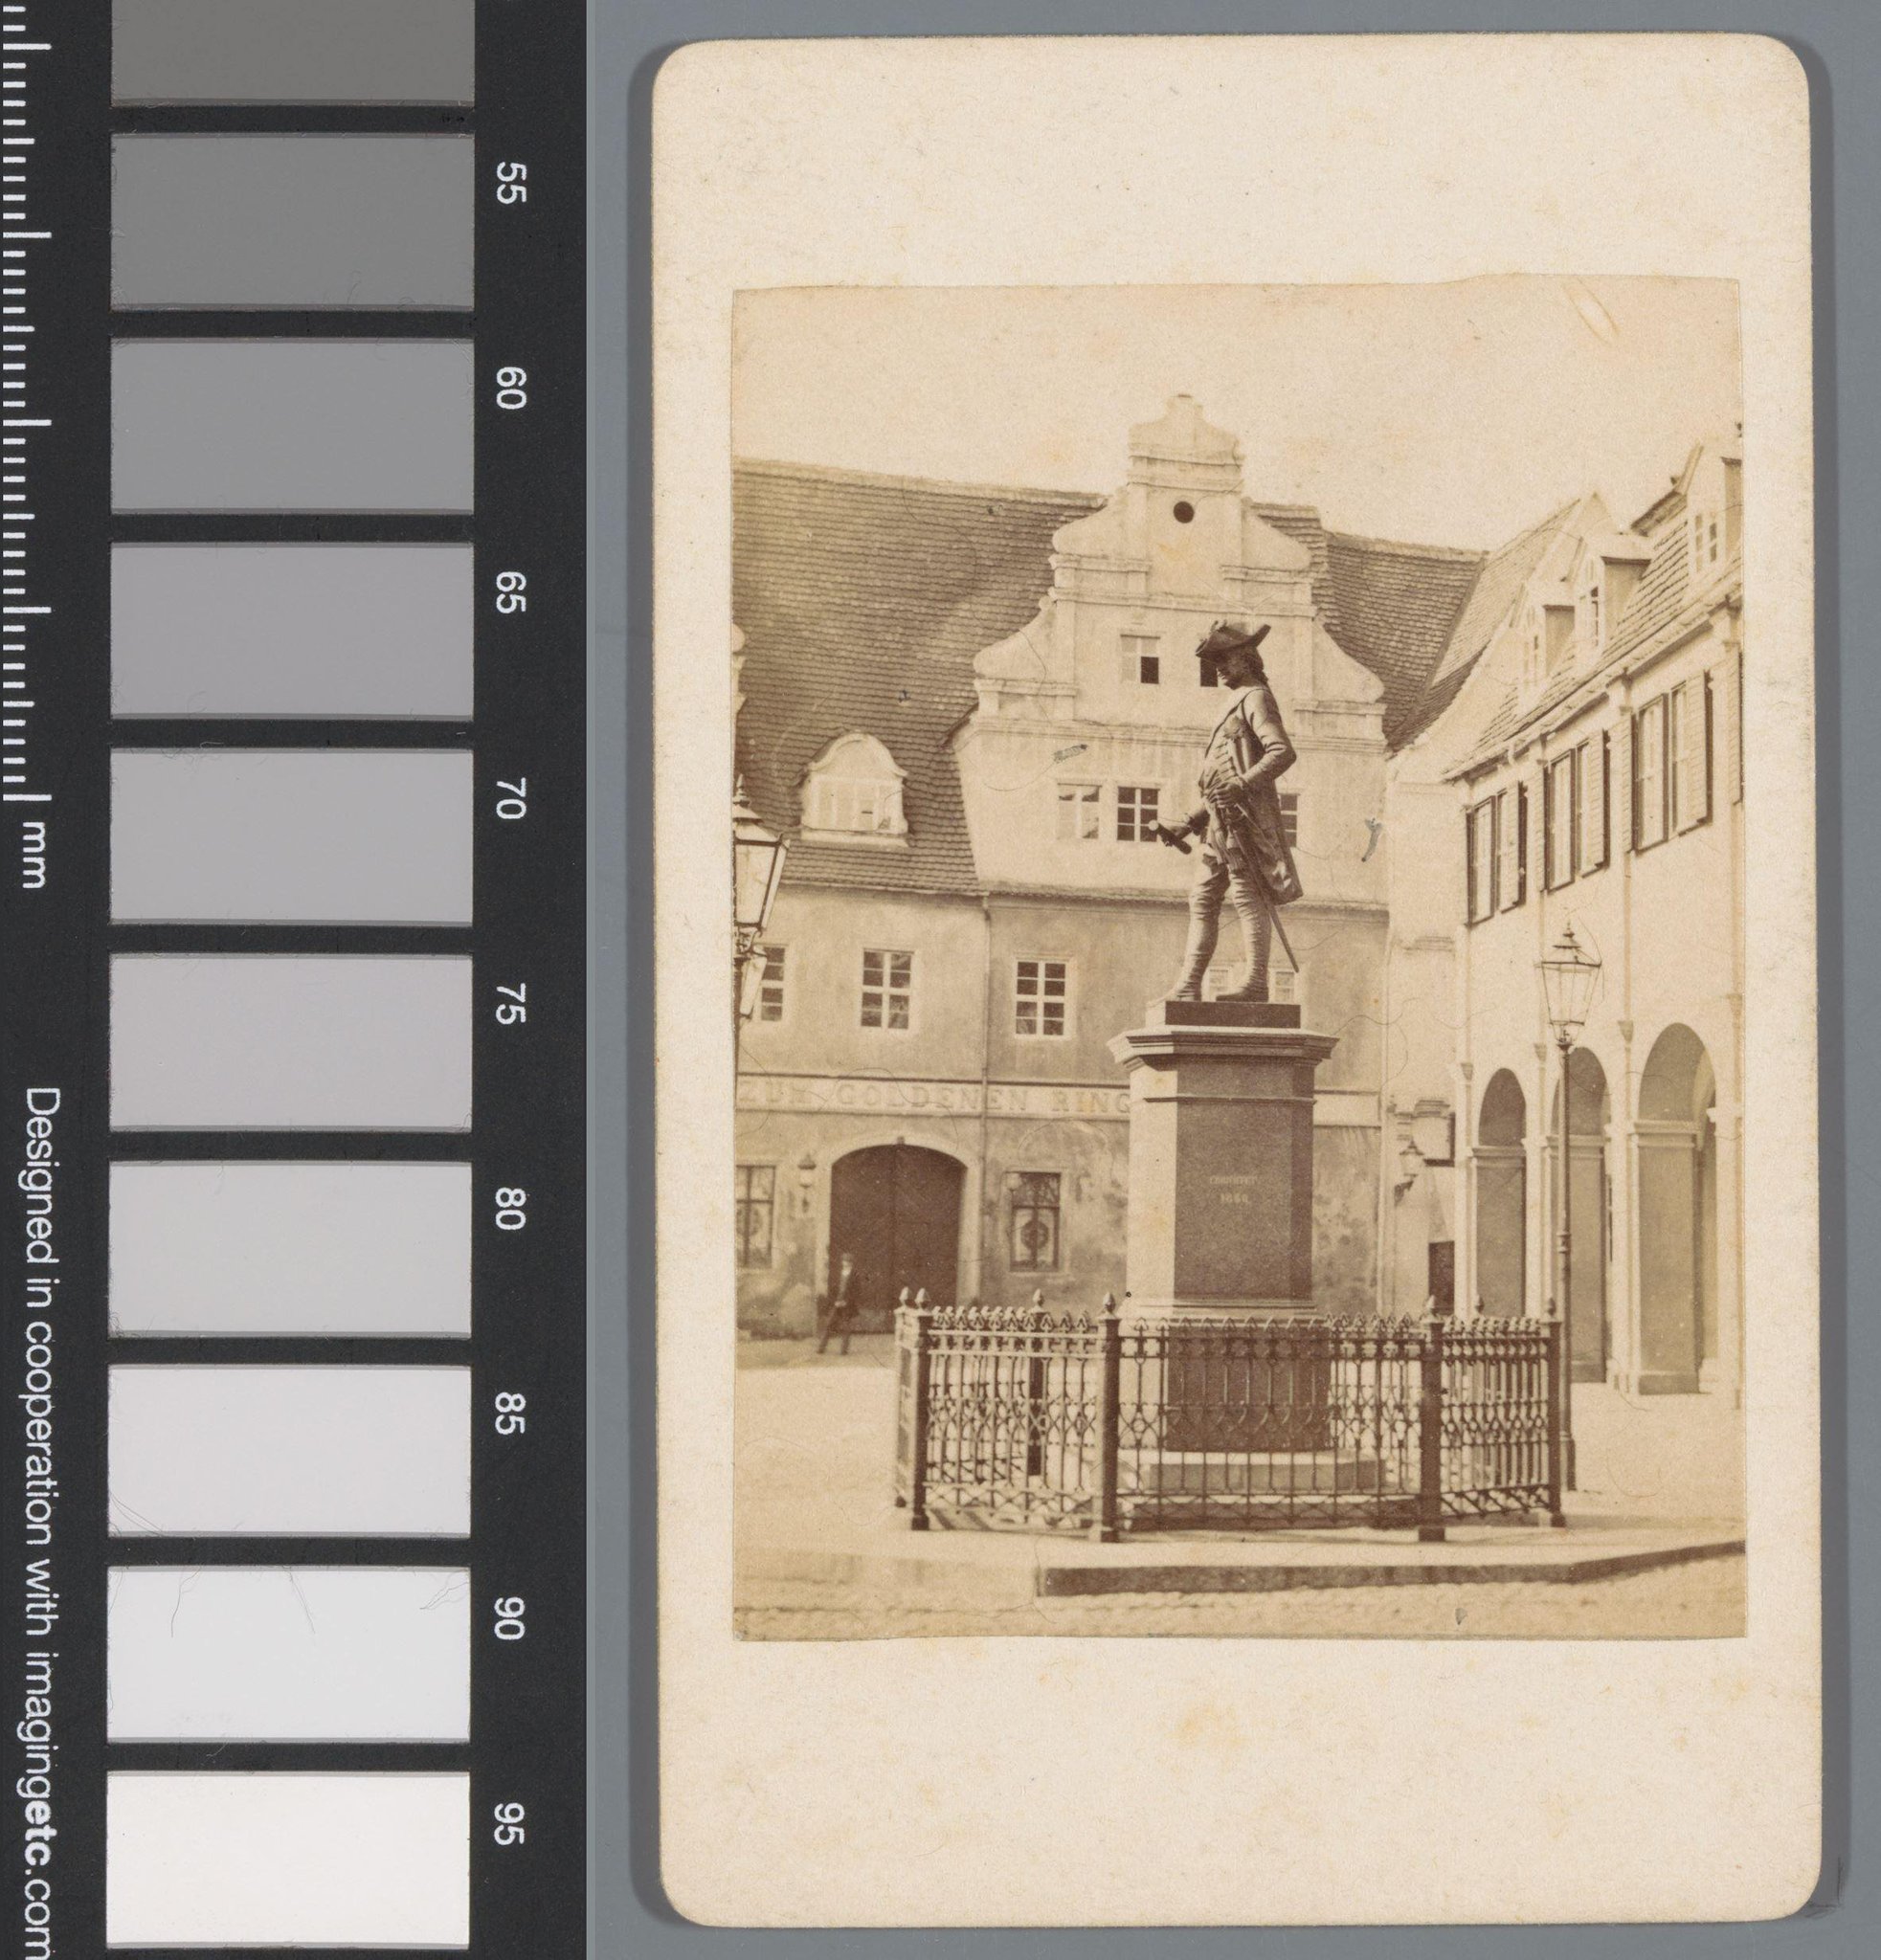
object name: photograph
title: Standbeeld van Fuerst Leopold von Dessau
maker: Anonymous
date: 1860-1875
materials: cardboard, paper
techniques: albumen print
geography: dessau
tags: monument, statue, village square, place